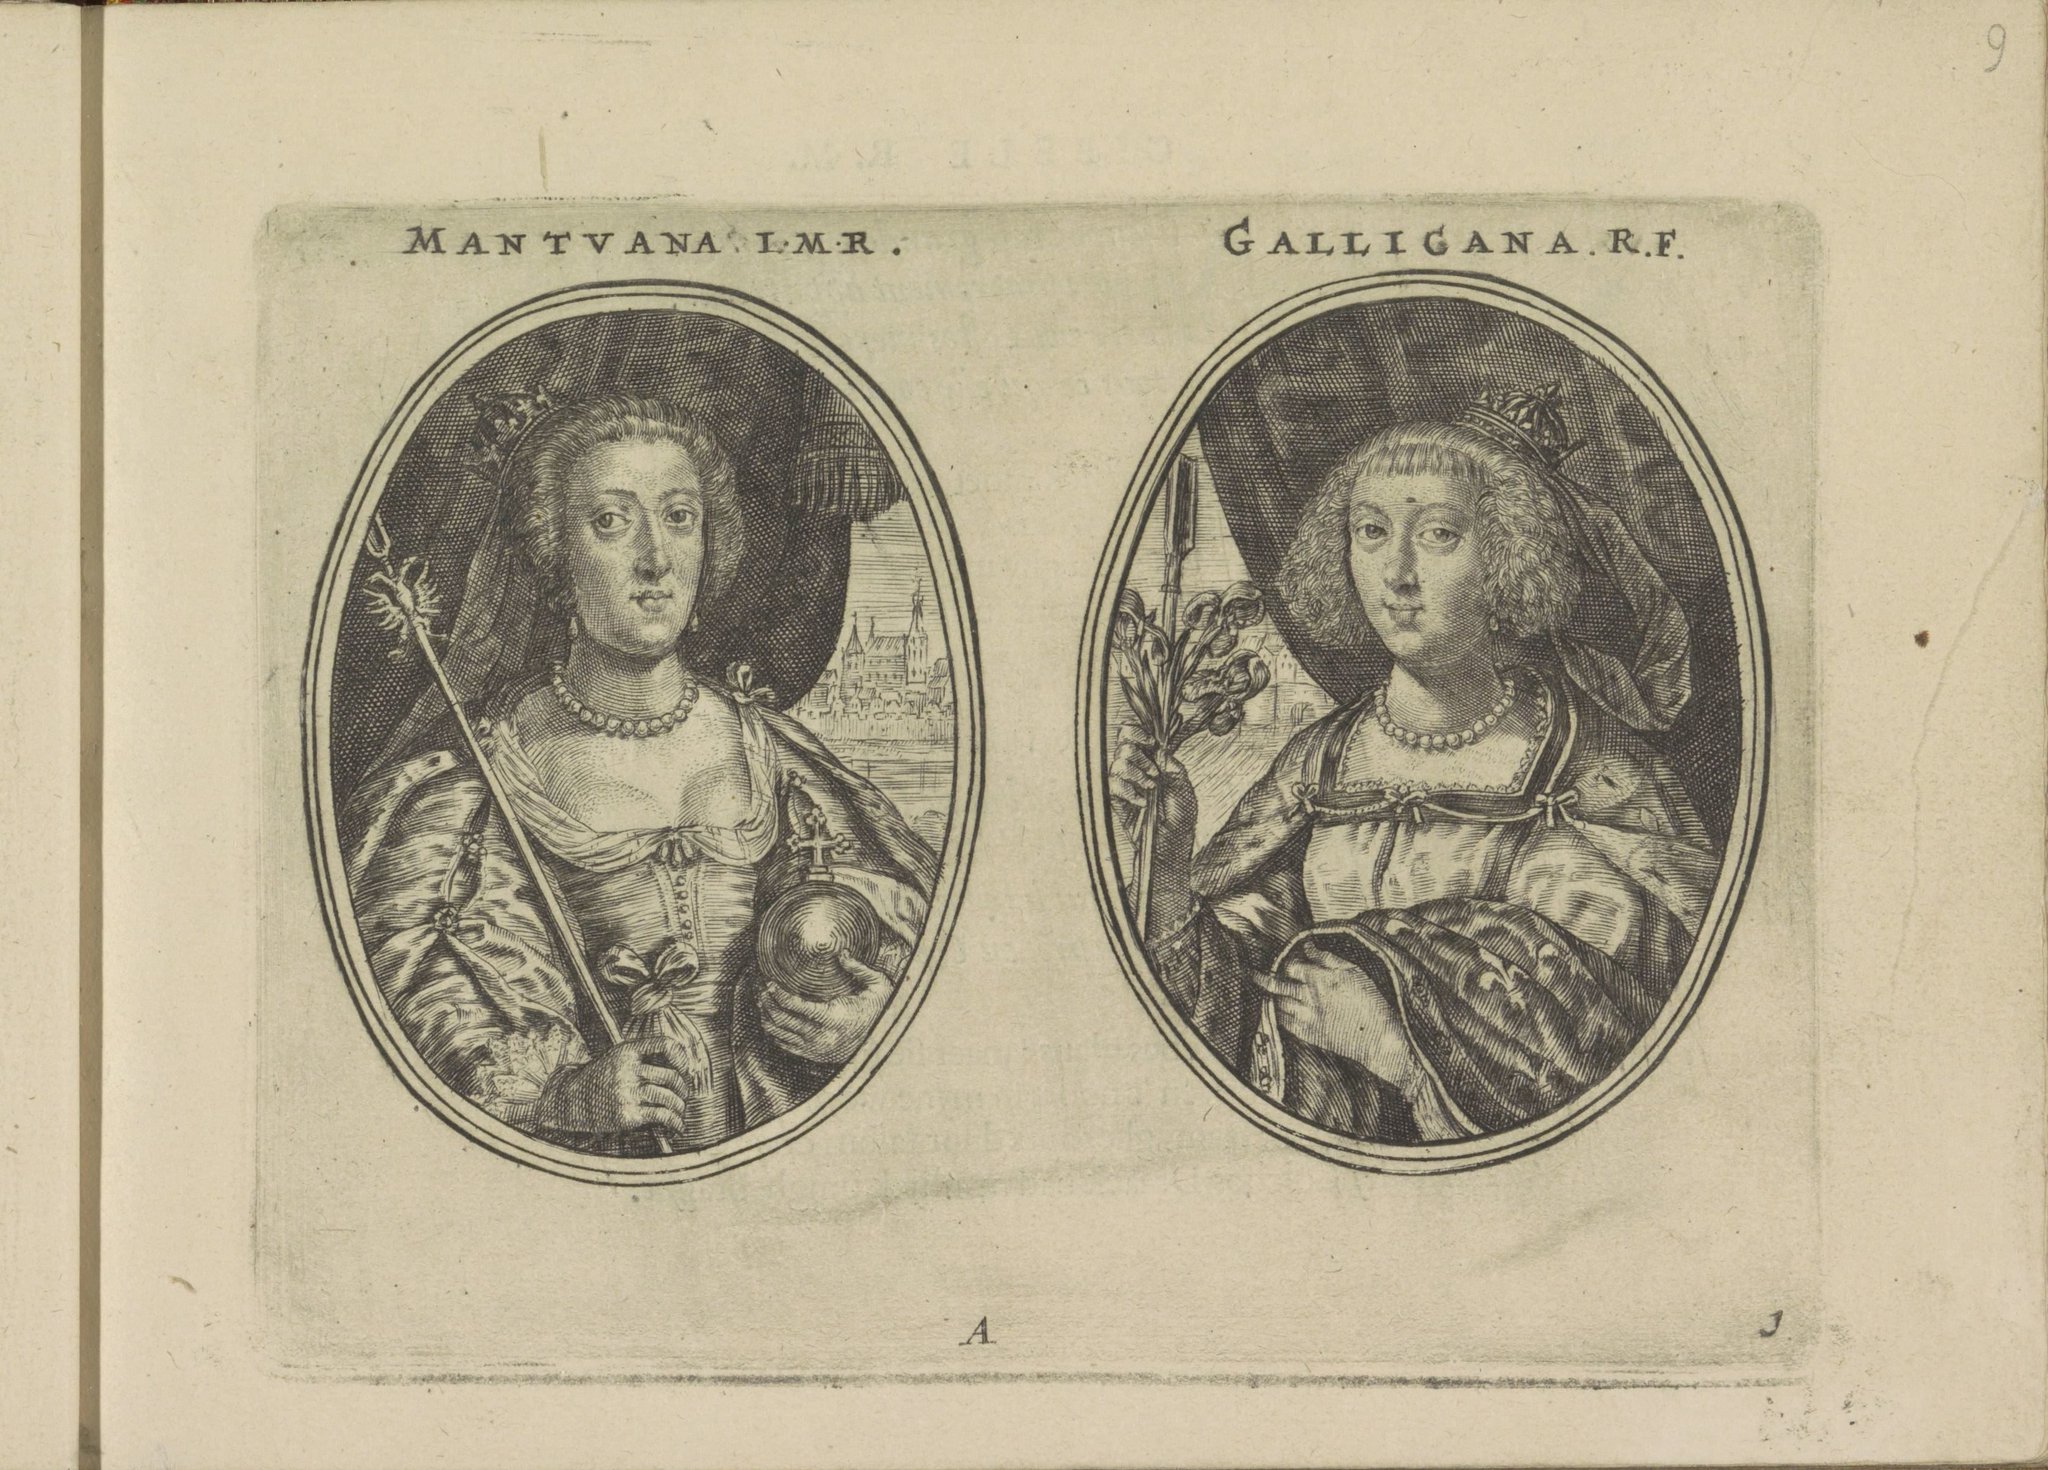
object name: album leaf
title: Portretten van Eleonora van Mantua en Anna van Oostenrijk, beiden als herderin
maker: crispijn van de passe (ii)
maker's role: draughtsman, print maker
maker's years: 1594-1670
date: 1640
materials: paper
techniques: engraving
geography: amsterdam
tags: vienna, female sex; woman, shepherd's crook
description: Twee voorstellingen op een albumblad. Links het portret van Eleonora van Mantua, vrouw van keizer Ferdinand II, als Mantuana I.M.R. Rechts Anna van Oostenrijk, koningin van Frankrijk, als Galligana R.F. Beide vrouwen hebben een herdersstaf in de hand. Die van de keizerin is versierd met een dubbelkoppige adelaar, een verwijzing naar het Heilige Roomse Rijk. Op de achtergrond van beide voorstellingen een stadsgezicht. Onderaan genummerd: A en 1. Het blad maakt deel uit van een album.